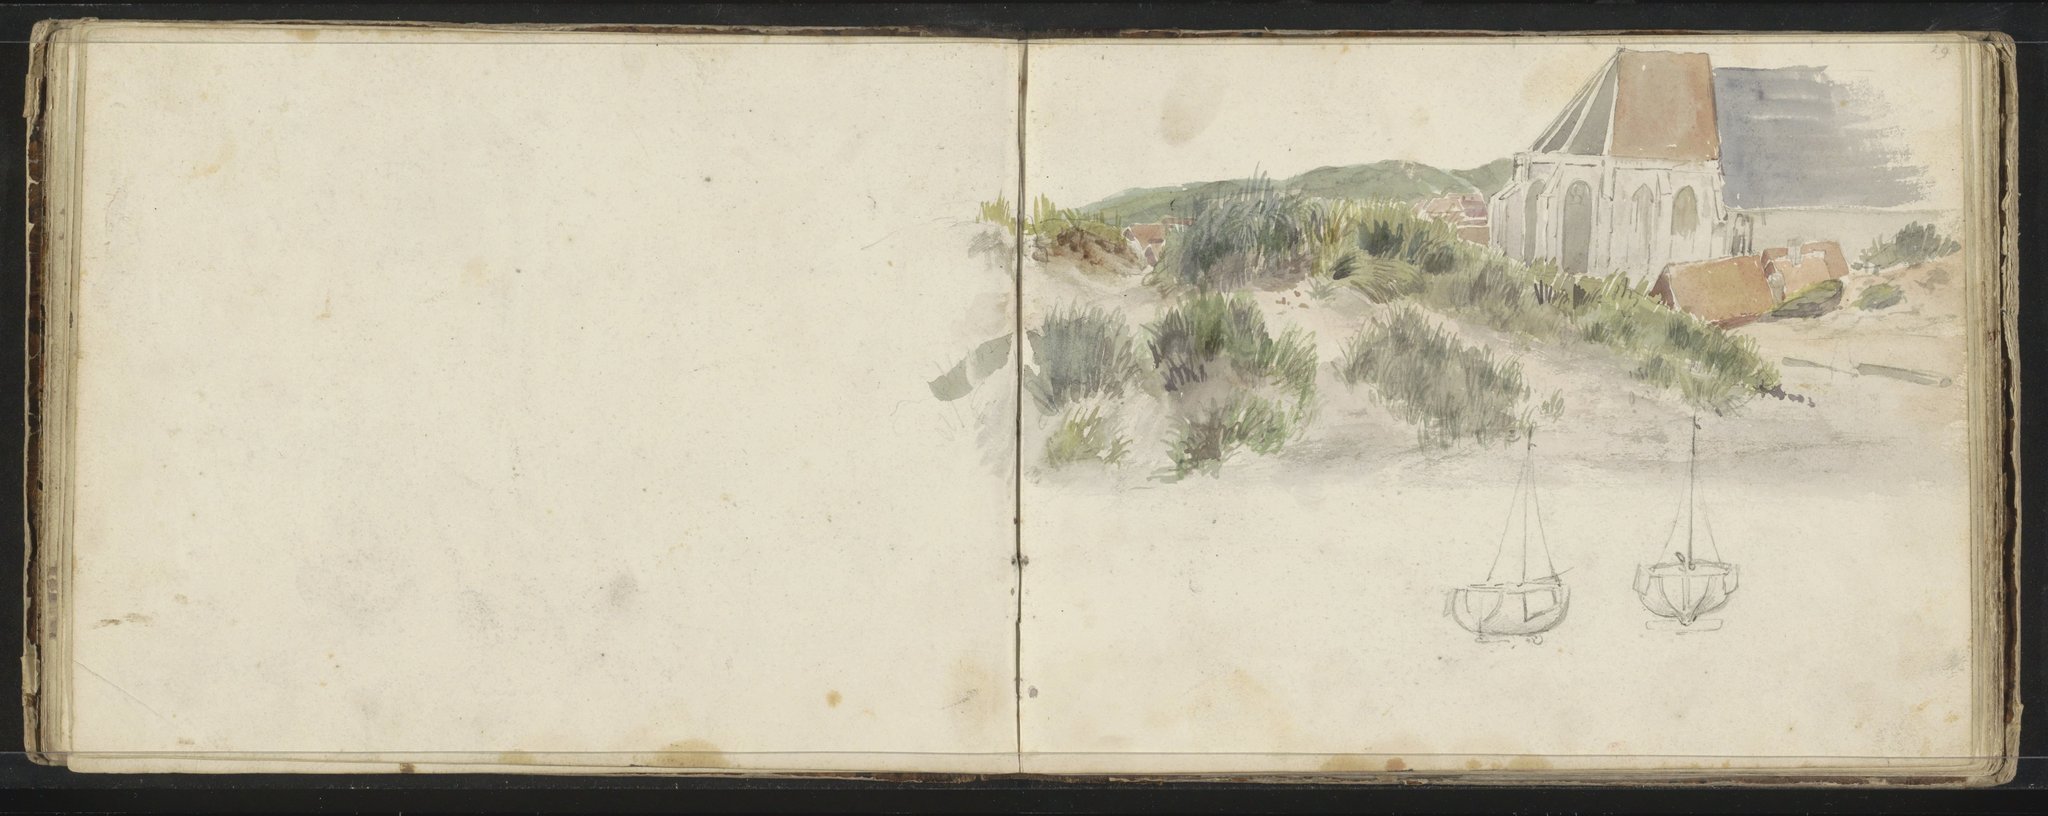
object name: sketchbook leaf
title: Oude Kerk van Scheveningen op het duin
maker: willem troost (ii)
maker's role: draughtsman, painter, print maker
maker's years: 1812-1893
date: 1822-1893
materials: paper, pencil, watercolor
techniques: brush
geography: scheveningen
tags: dunes (sea not visible); in the dunes, church (exterior)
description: Tevens studies van vissersboten. Blad 28 verso en 29 recto uit een schetsboek met 36 bladen.